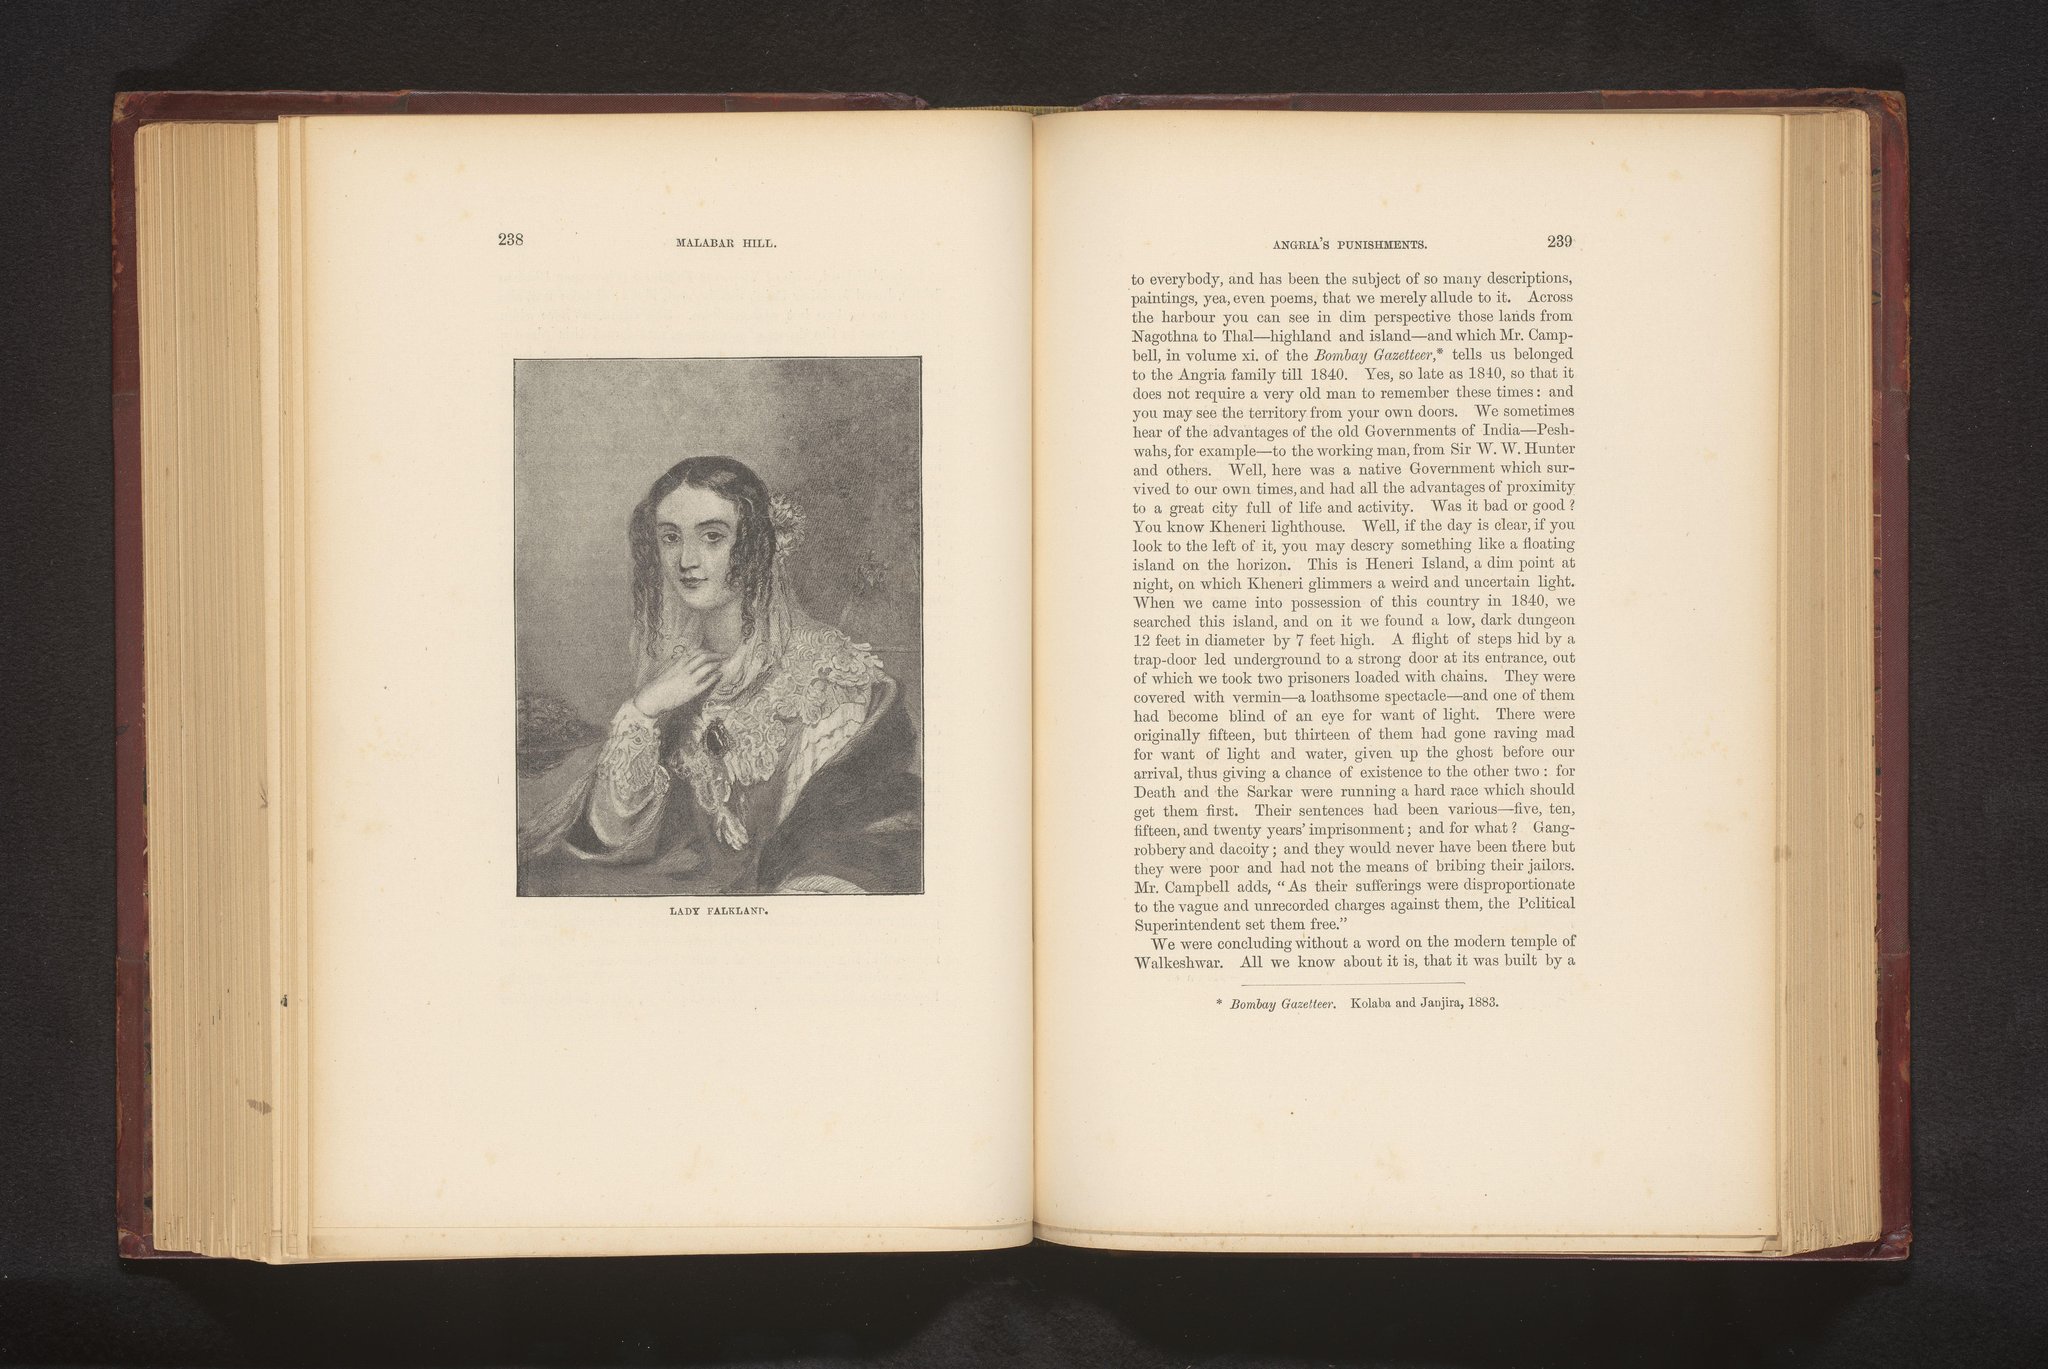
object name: photomechanical print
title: Lady Falkland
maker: Anonymous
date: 1883-1893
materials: paper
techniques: autotype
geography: mumbai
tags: adult woman